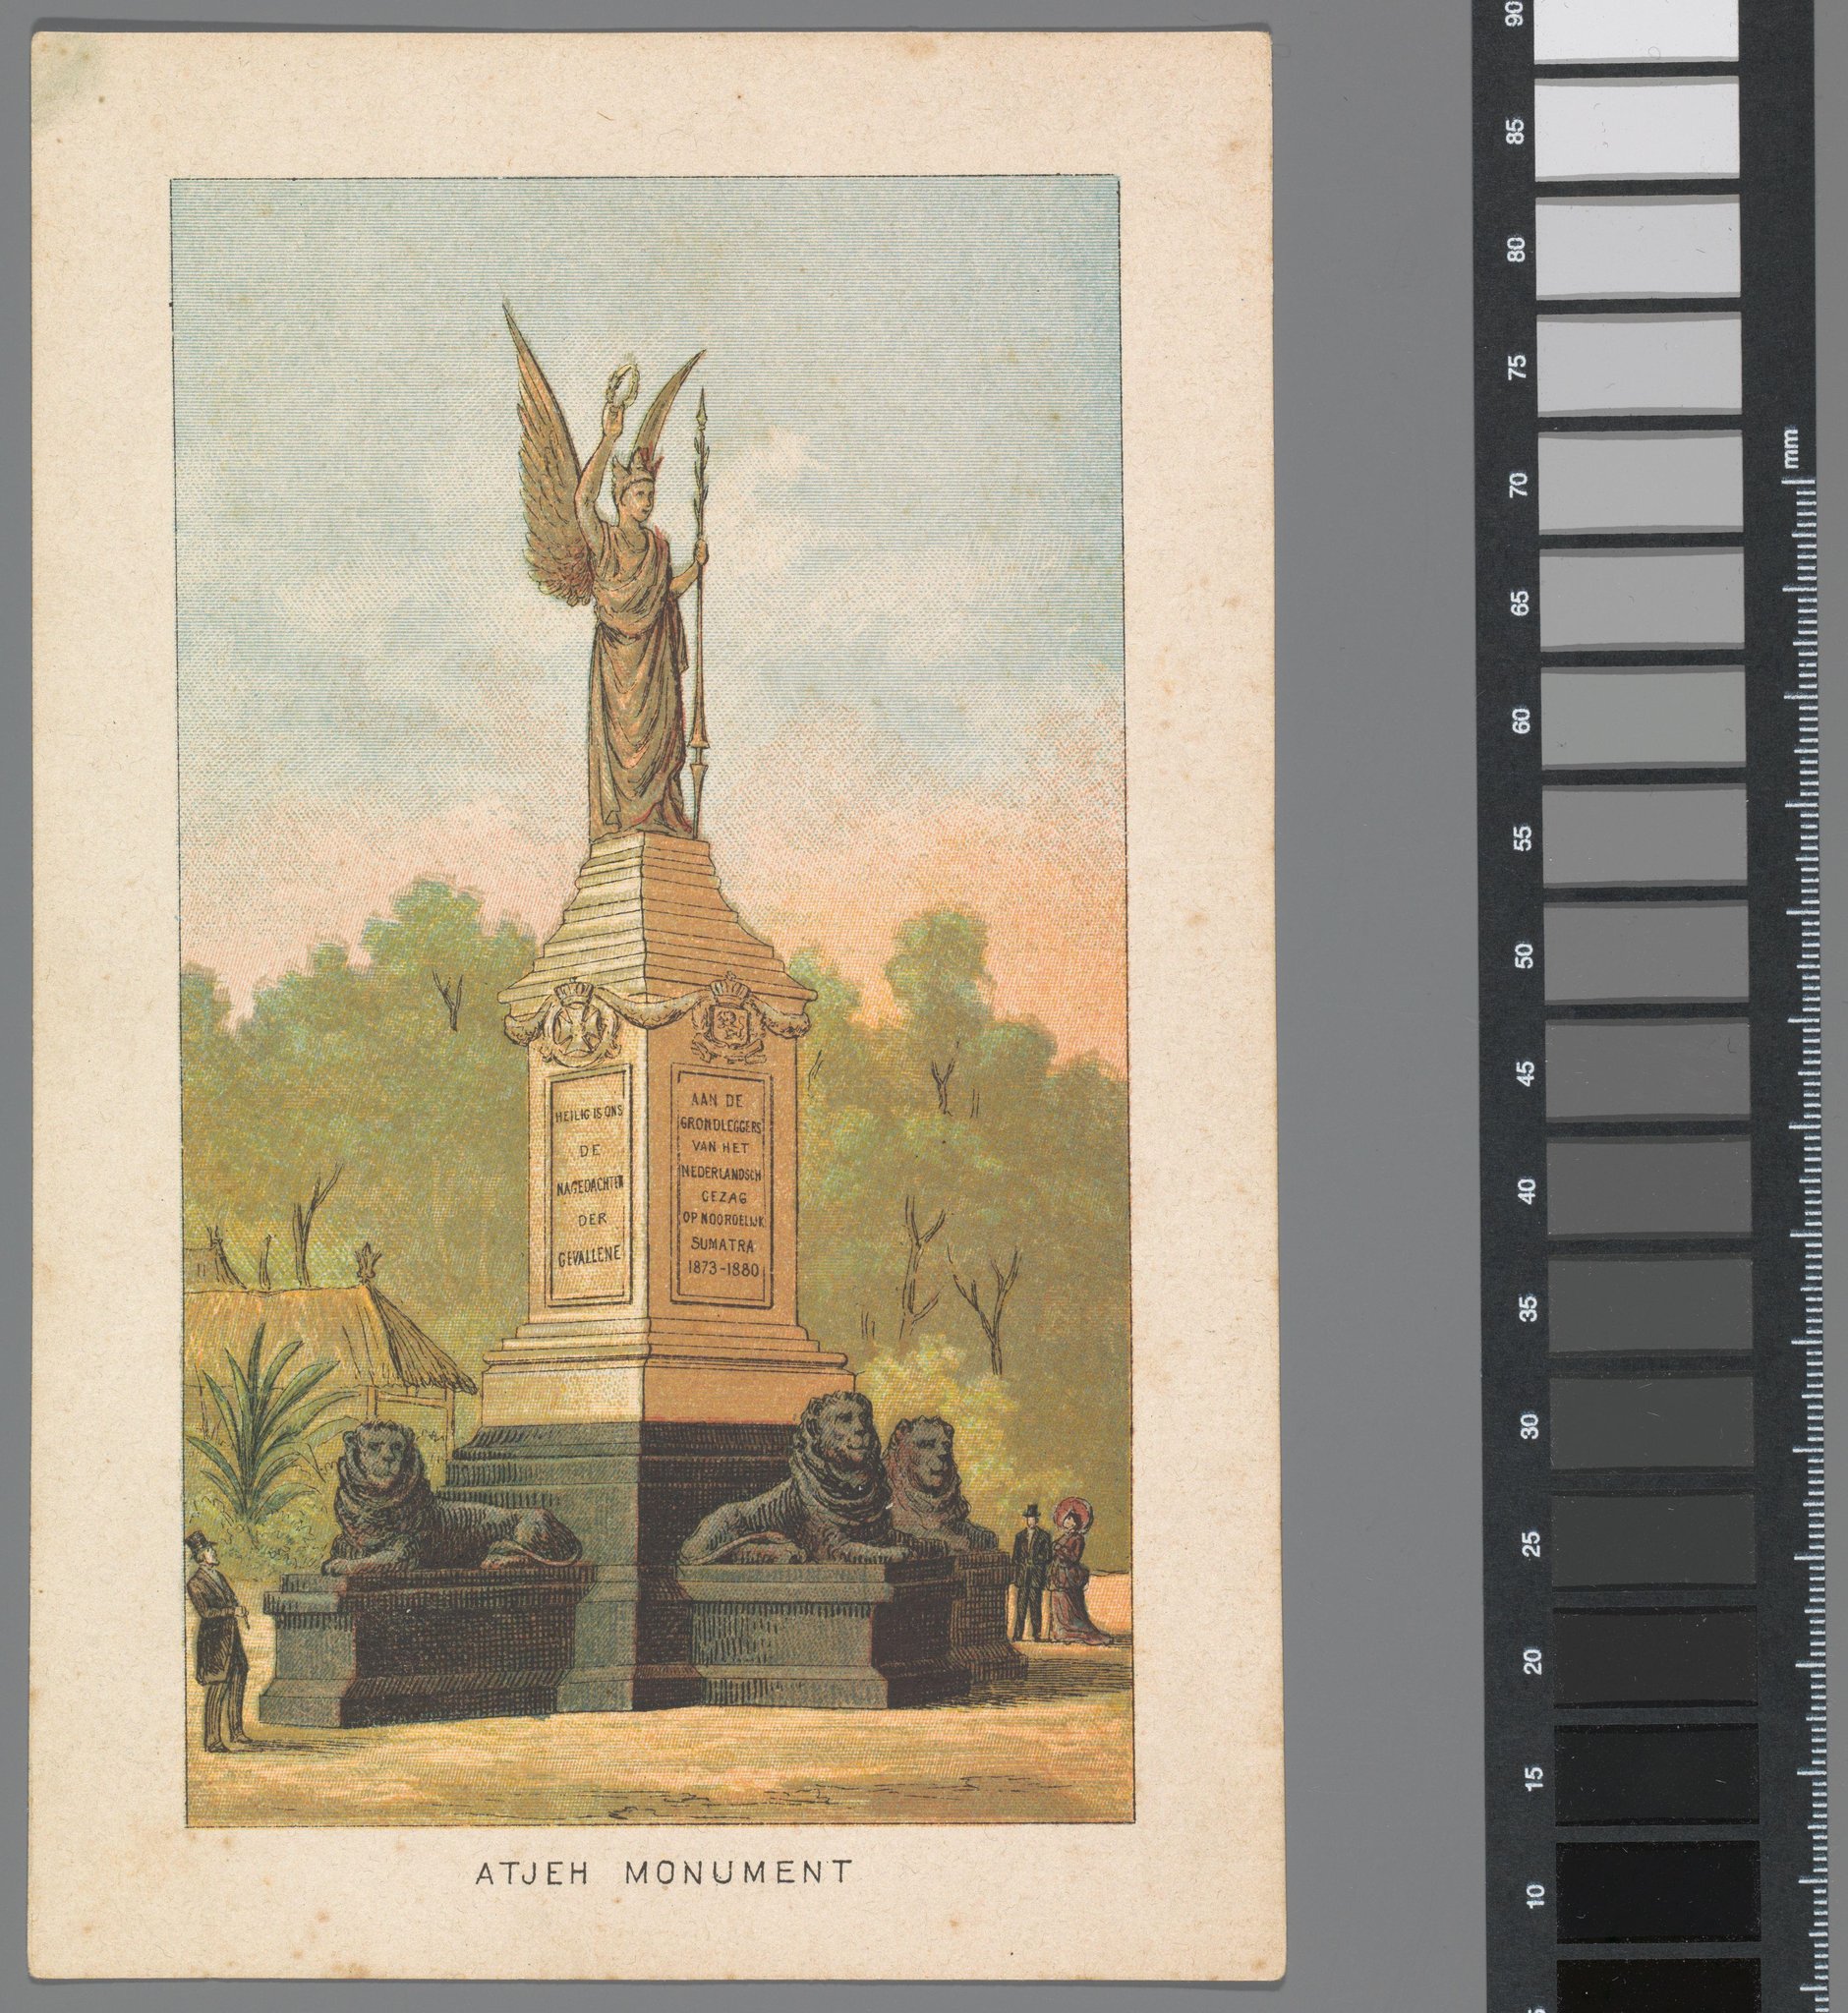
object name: print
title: Atjeh monument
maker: Anonymous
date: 1883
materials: paper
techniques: chromolithography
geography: netherlands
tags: world fair, world exhibition, amsterdam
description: Het Atjehmonument van architect P.H.J.Cuypers met een bronzen Victorie door de beeldhouwer Bart van Hove. Opgericht op de Wereldtentoonstelling op het Museumplein te Amsterdam. Onderdeel van een groep van zestien platen en een plattegrond van de Wereldtentoonstelling in Amsterdam van 1 mei tot 1 oktober 1883. Uitgave van het Nieuws van den Dag.